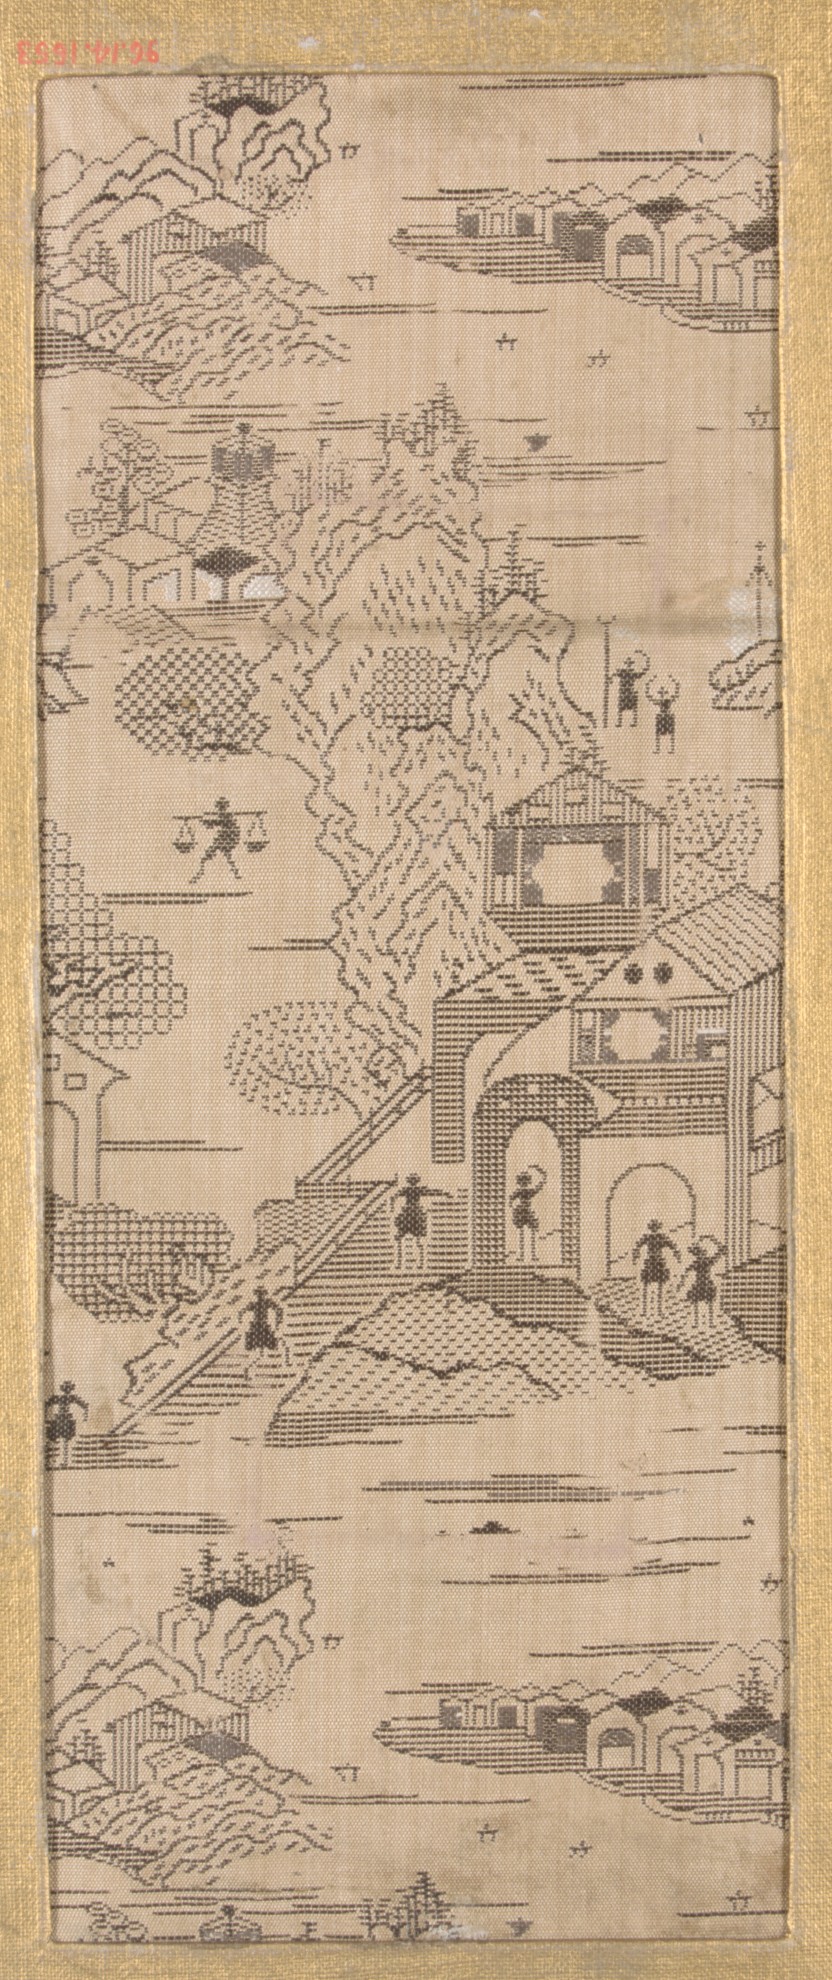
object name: piece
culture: japanese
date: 1701-1900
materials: silk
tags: houses